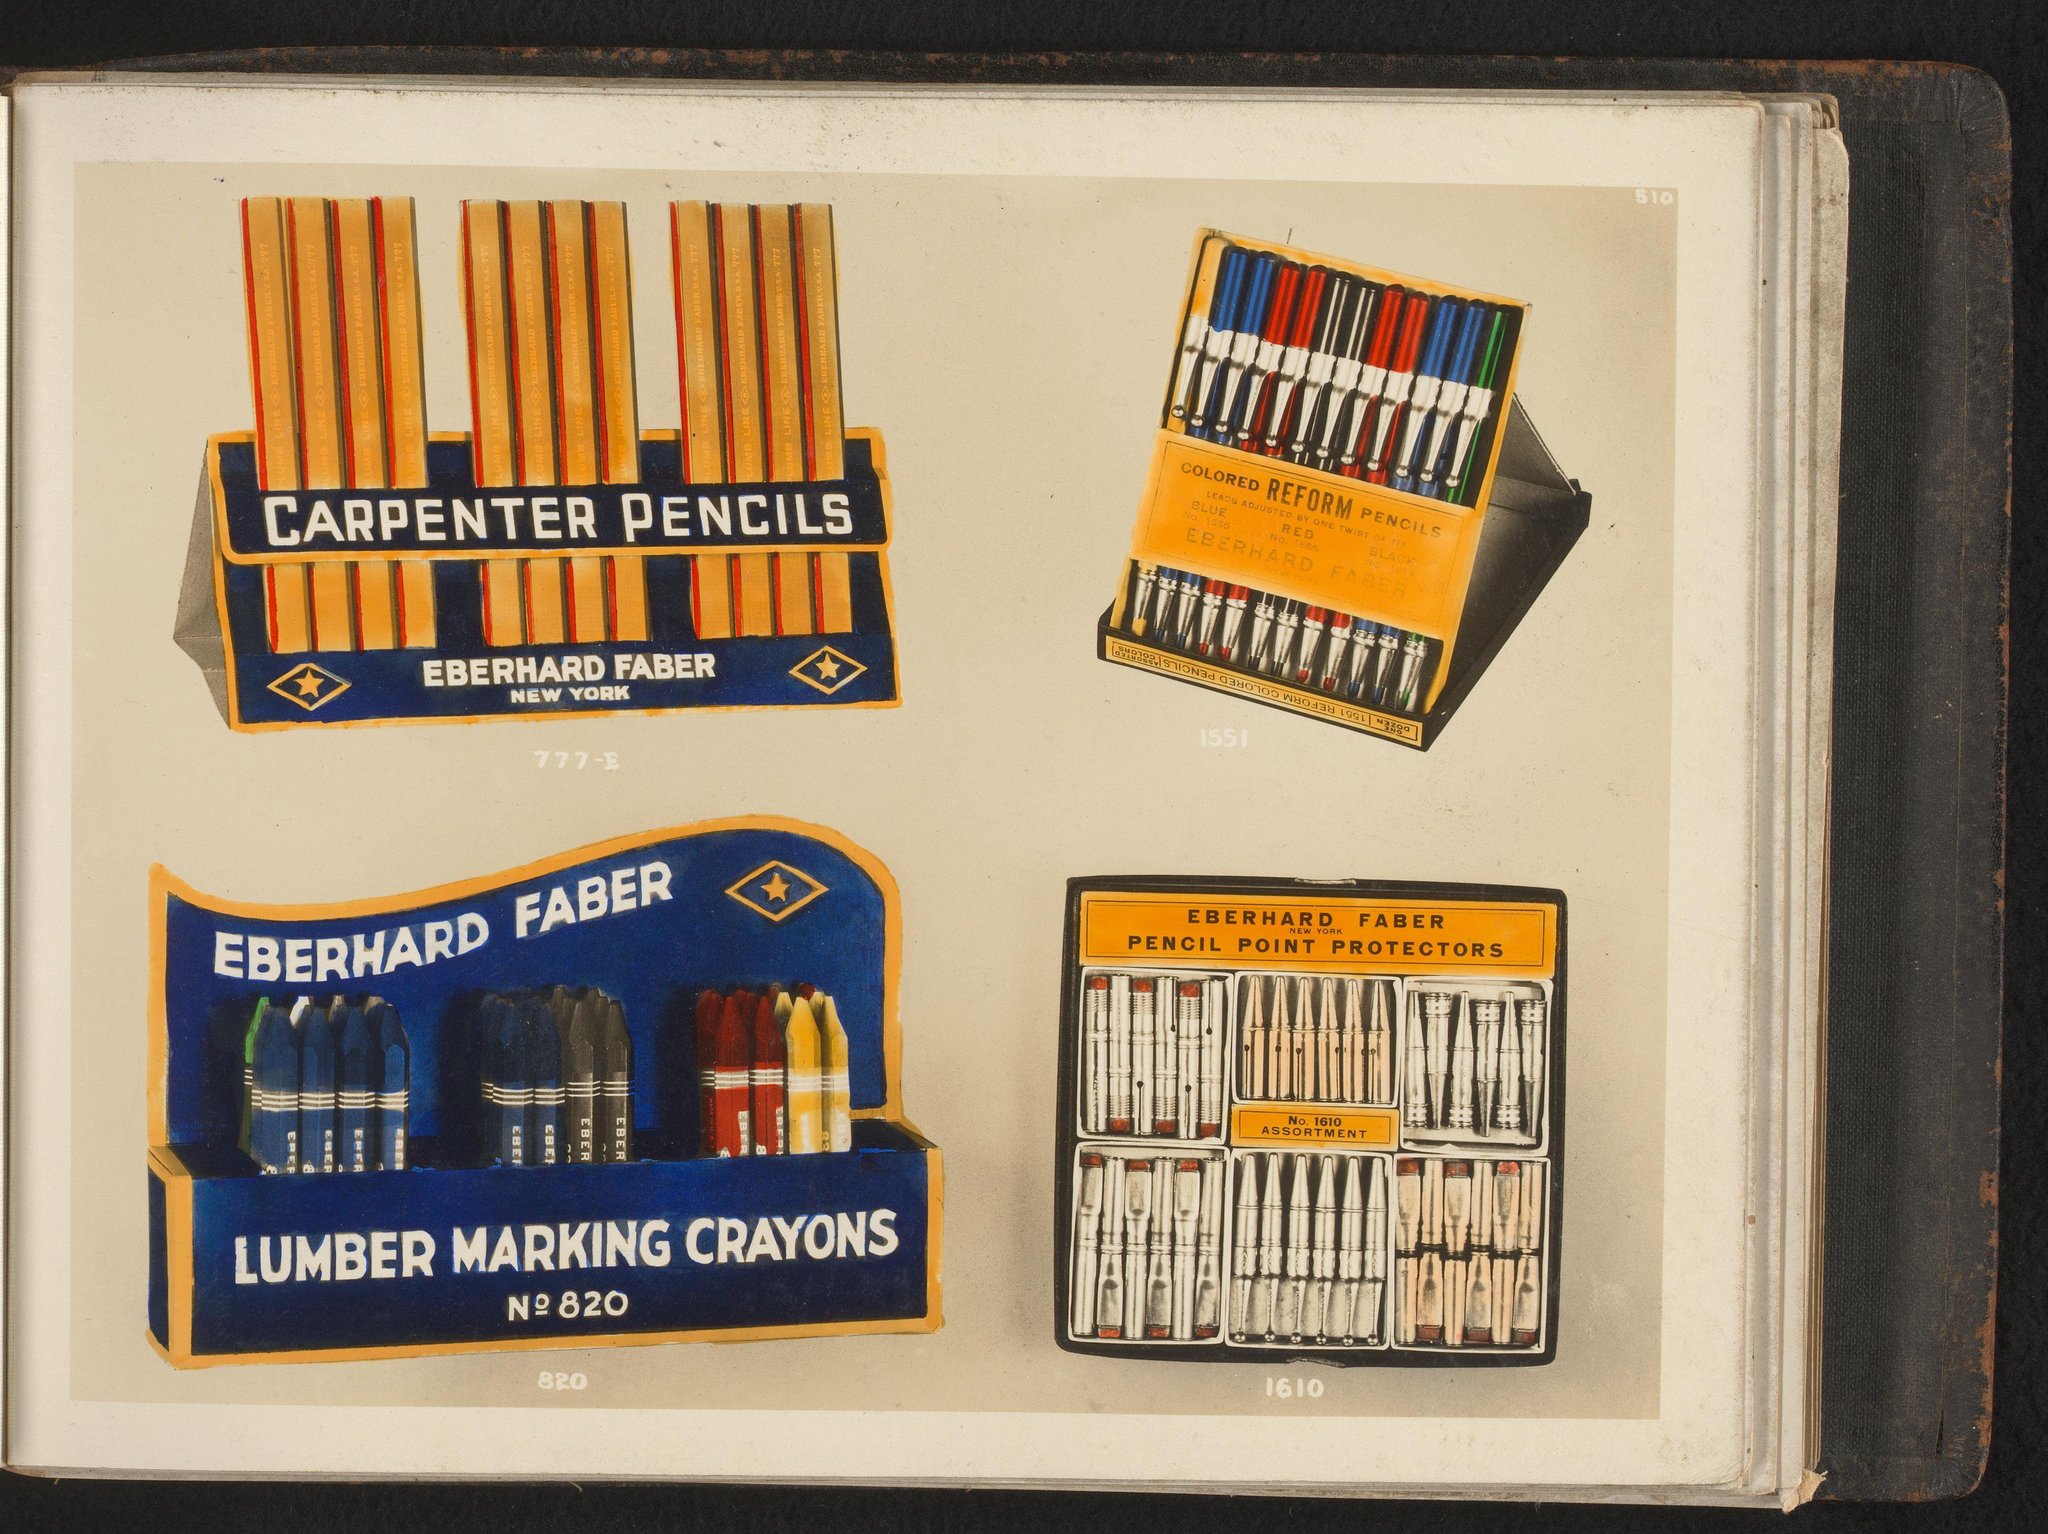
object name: photograph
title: Standaarden met potloden van Eberhard Faber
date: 1915-1935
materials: paper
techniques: gelatin silver print, hand coloring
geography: springfield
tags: pencil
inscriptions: number: ‘510’, stamp: ‘Paramount/ Commercial Studios/ 145 Chestnut St./ Springfield - Mass.’